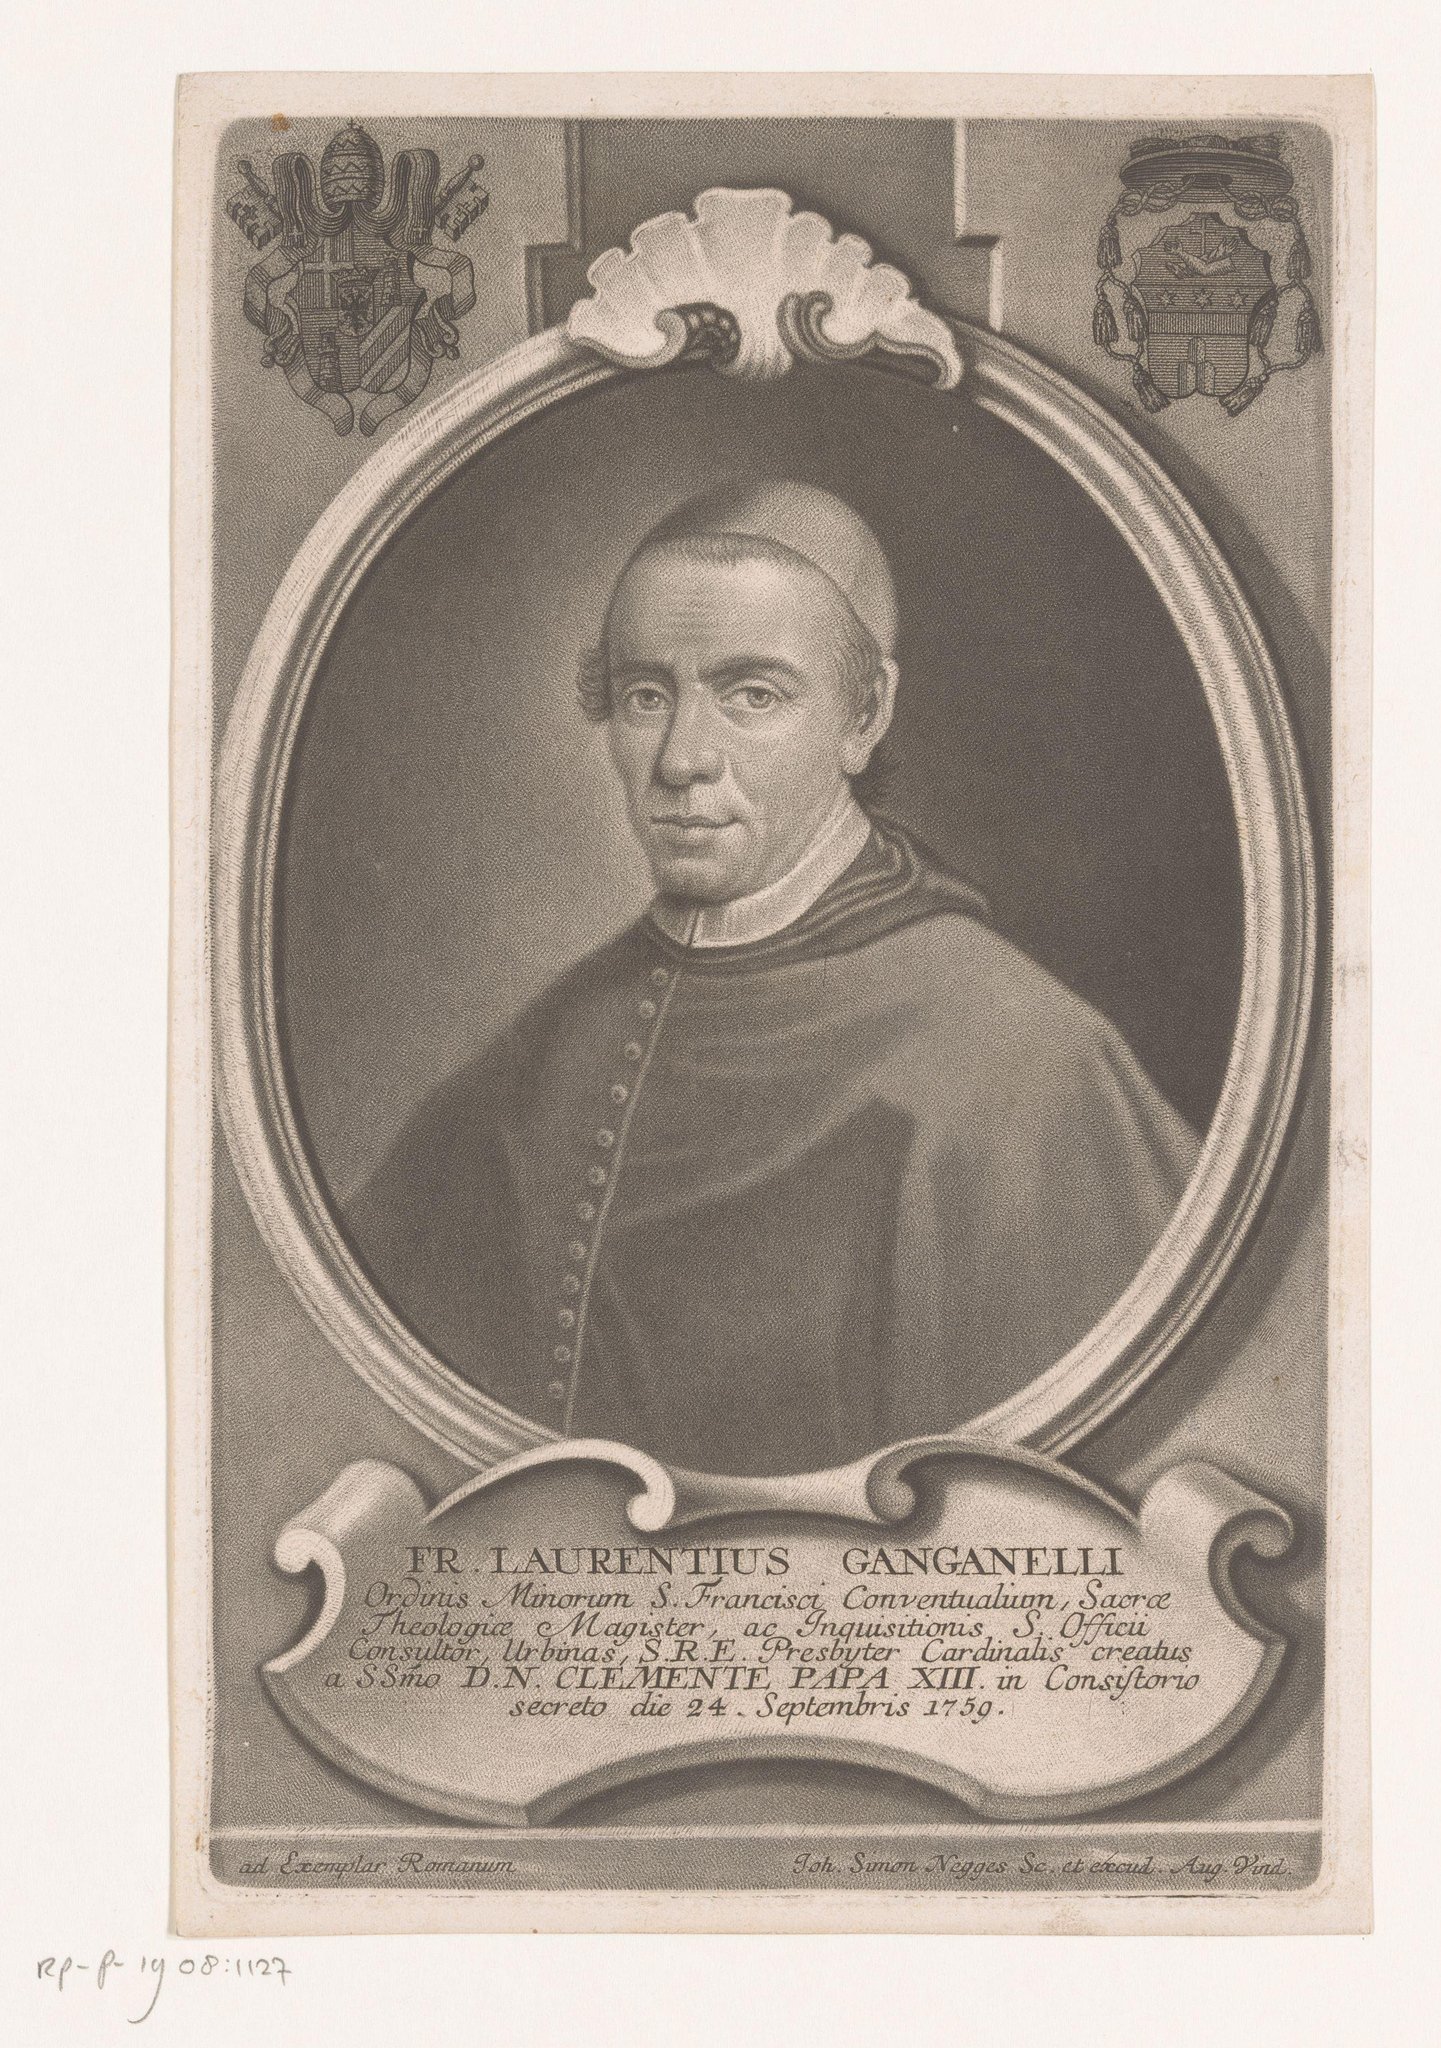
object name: print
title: Portret van Clemens XIV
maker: johann simon negges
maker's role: print maker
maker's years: 1726-1792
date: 1736-1792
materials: paper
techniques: mezzotint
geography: augsburg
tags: rome, historical persons, pope, armorial bearing, heraldry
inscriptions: collector's mark: Lugt 2228